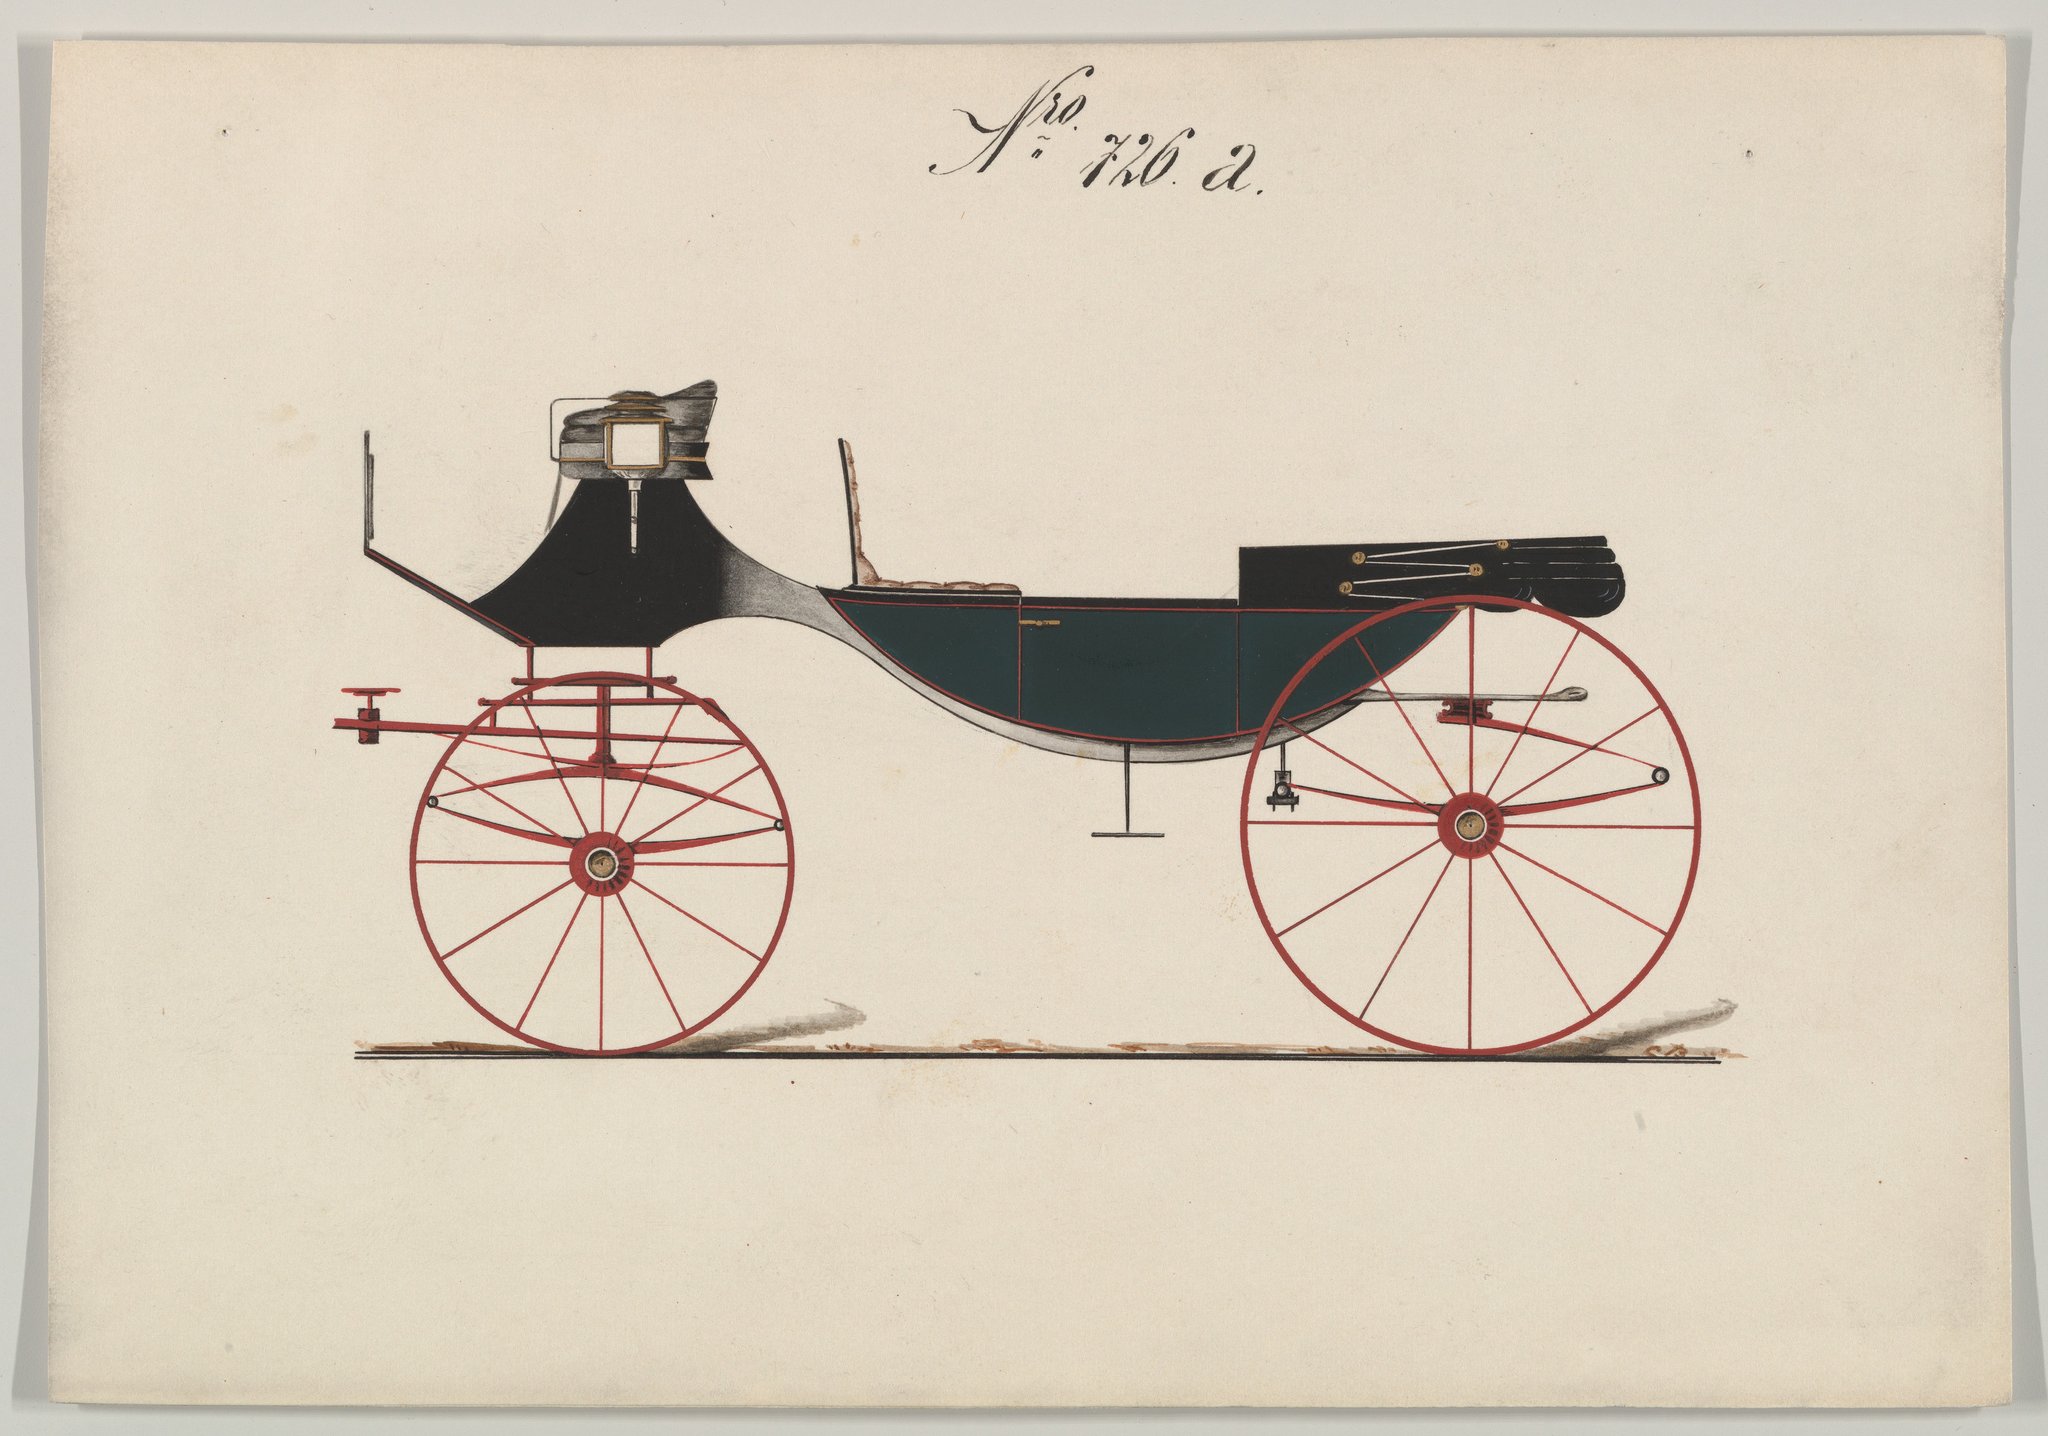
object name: drawing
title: Design for Vis-à-vis/ Caleche, no. 726a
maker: brewster & co.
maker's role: manufacturer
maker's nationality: american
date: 1850-1870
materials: gouache, ink, paint, watercolor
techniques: pen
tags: carriages